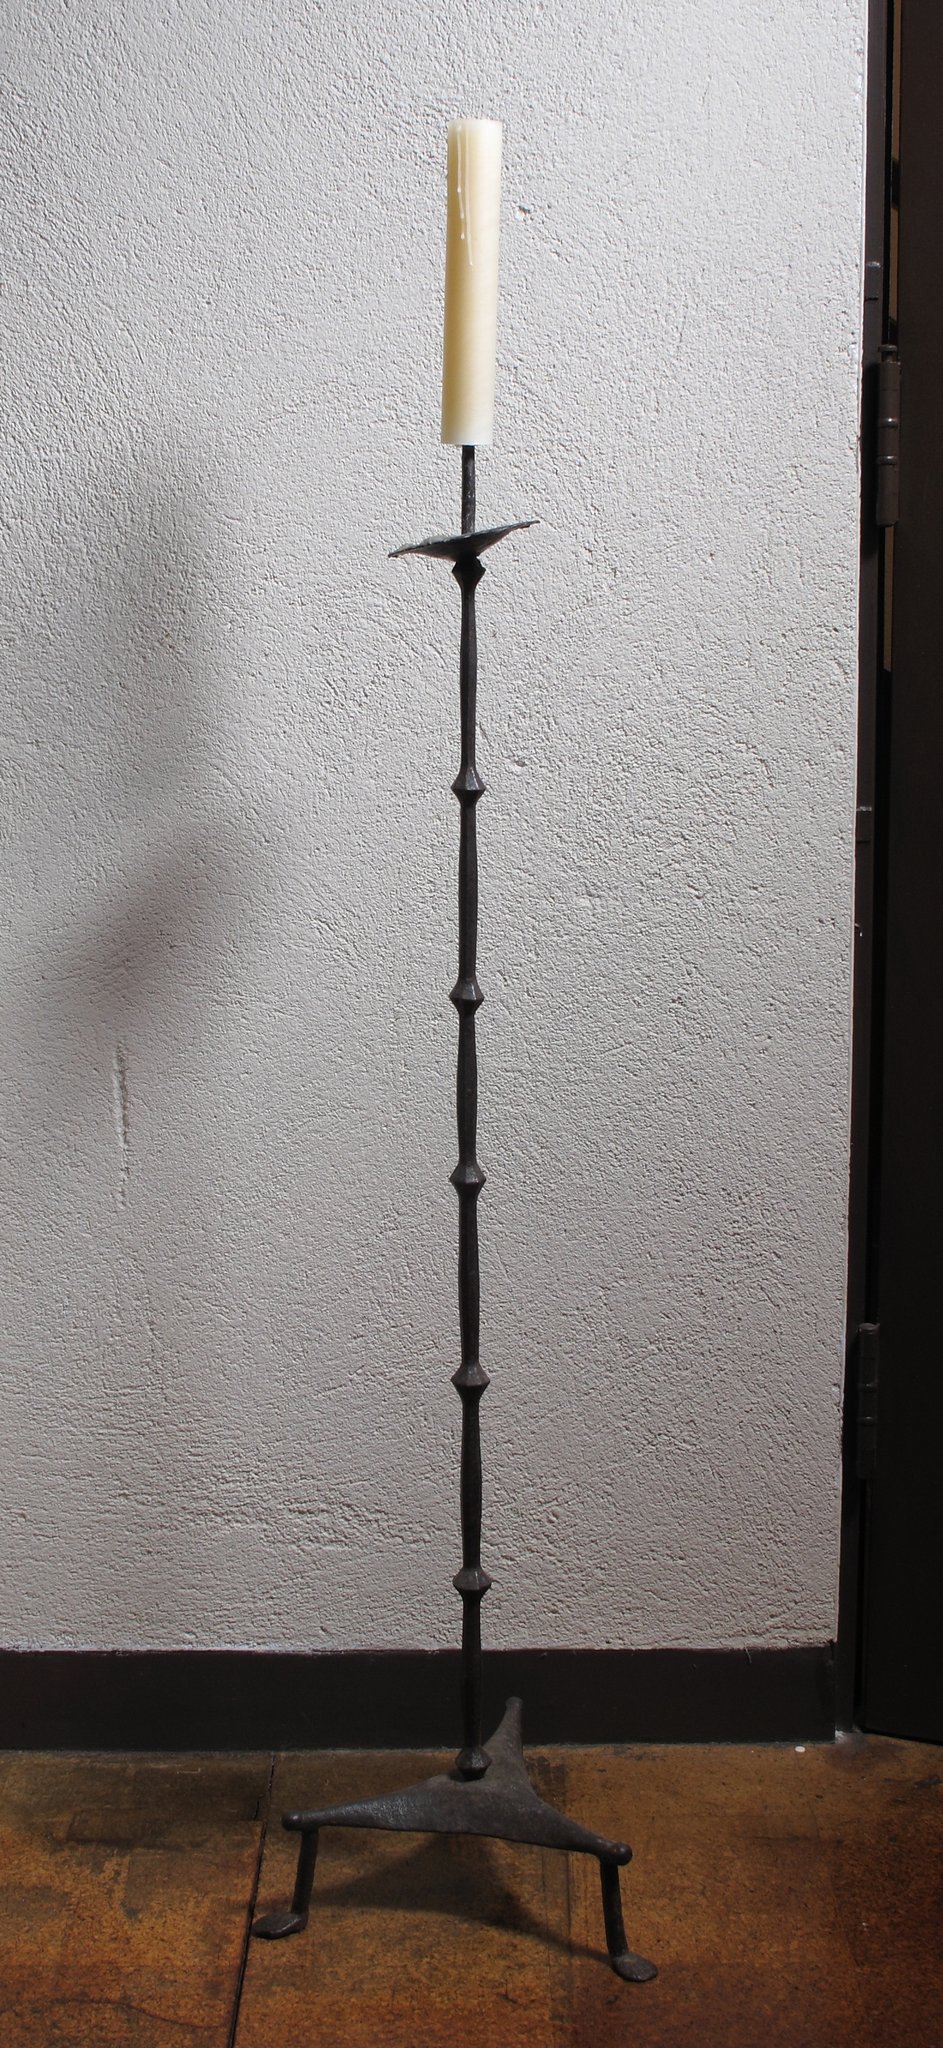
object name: candlestick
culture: european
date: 1401-1600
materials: iron